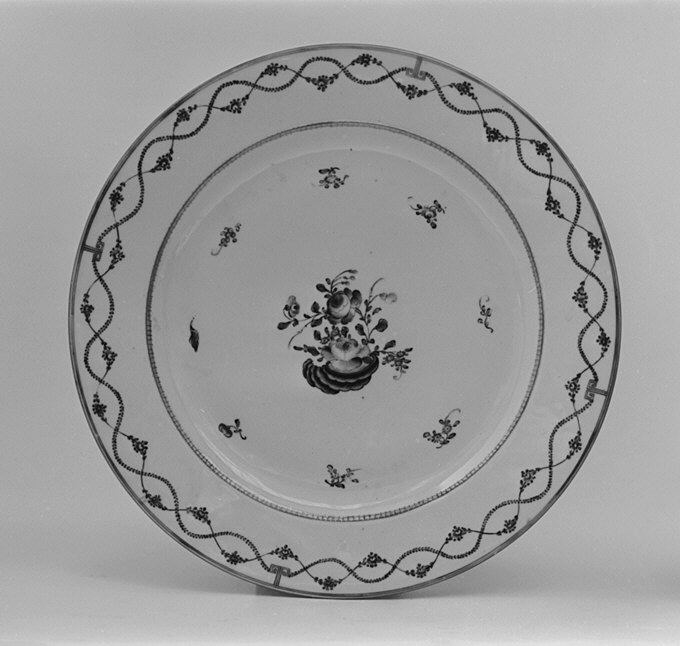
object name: plate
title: Plate (part of a service)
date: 1790-1800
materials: hard paste porcelain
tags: flowers